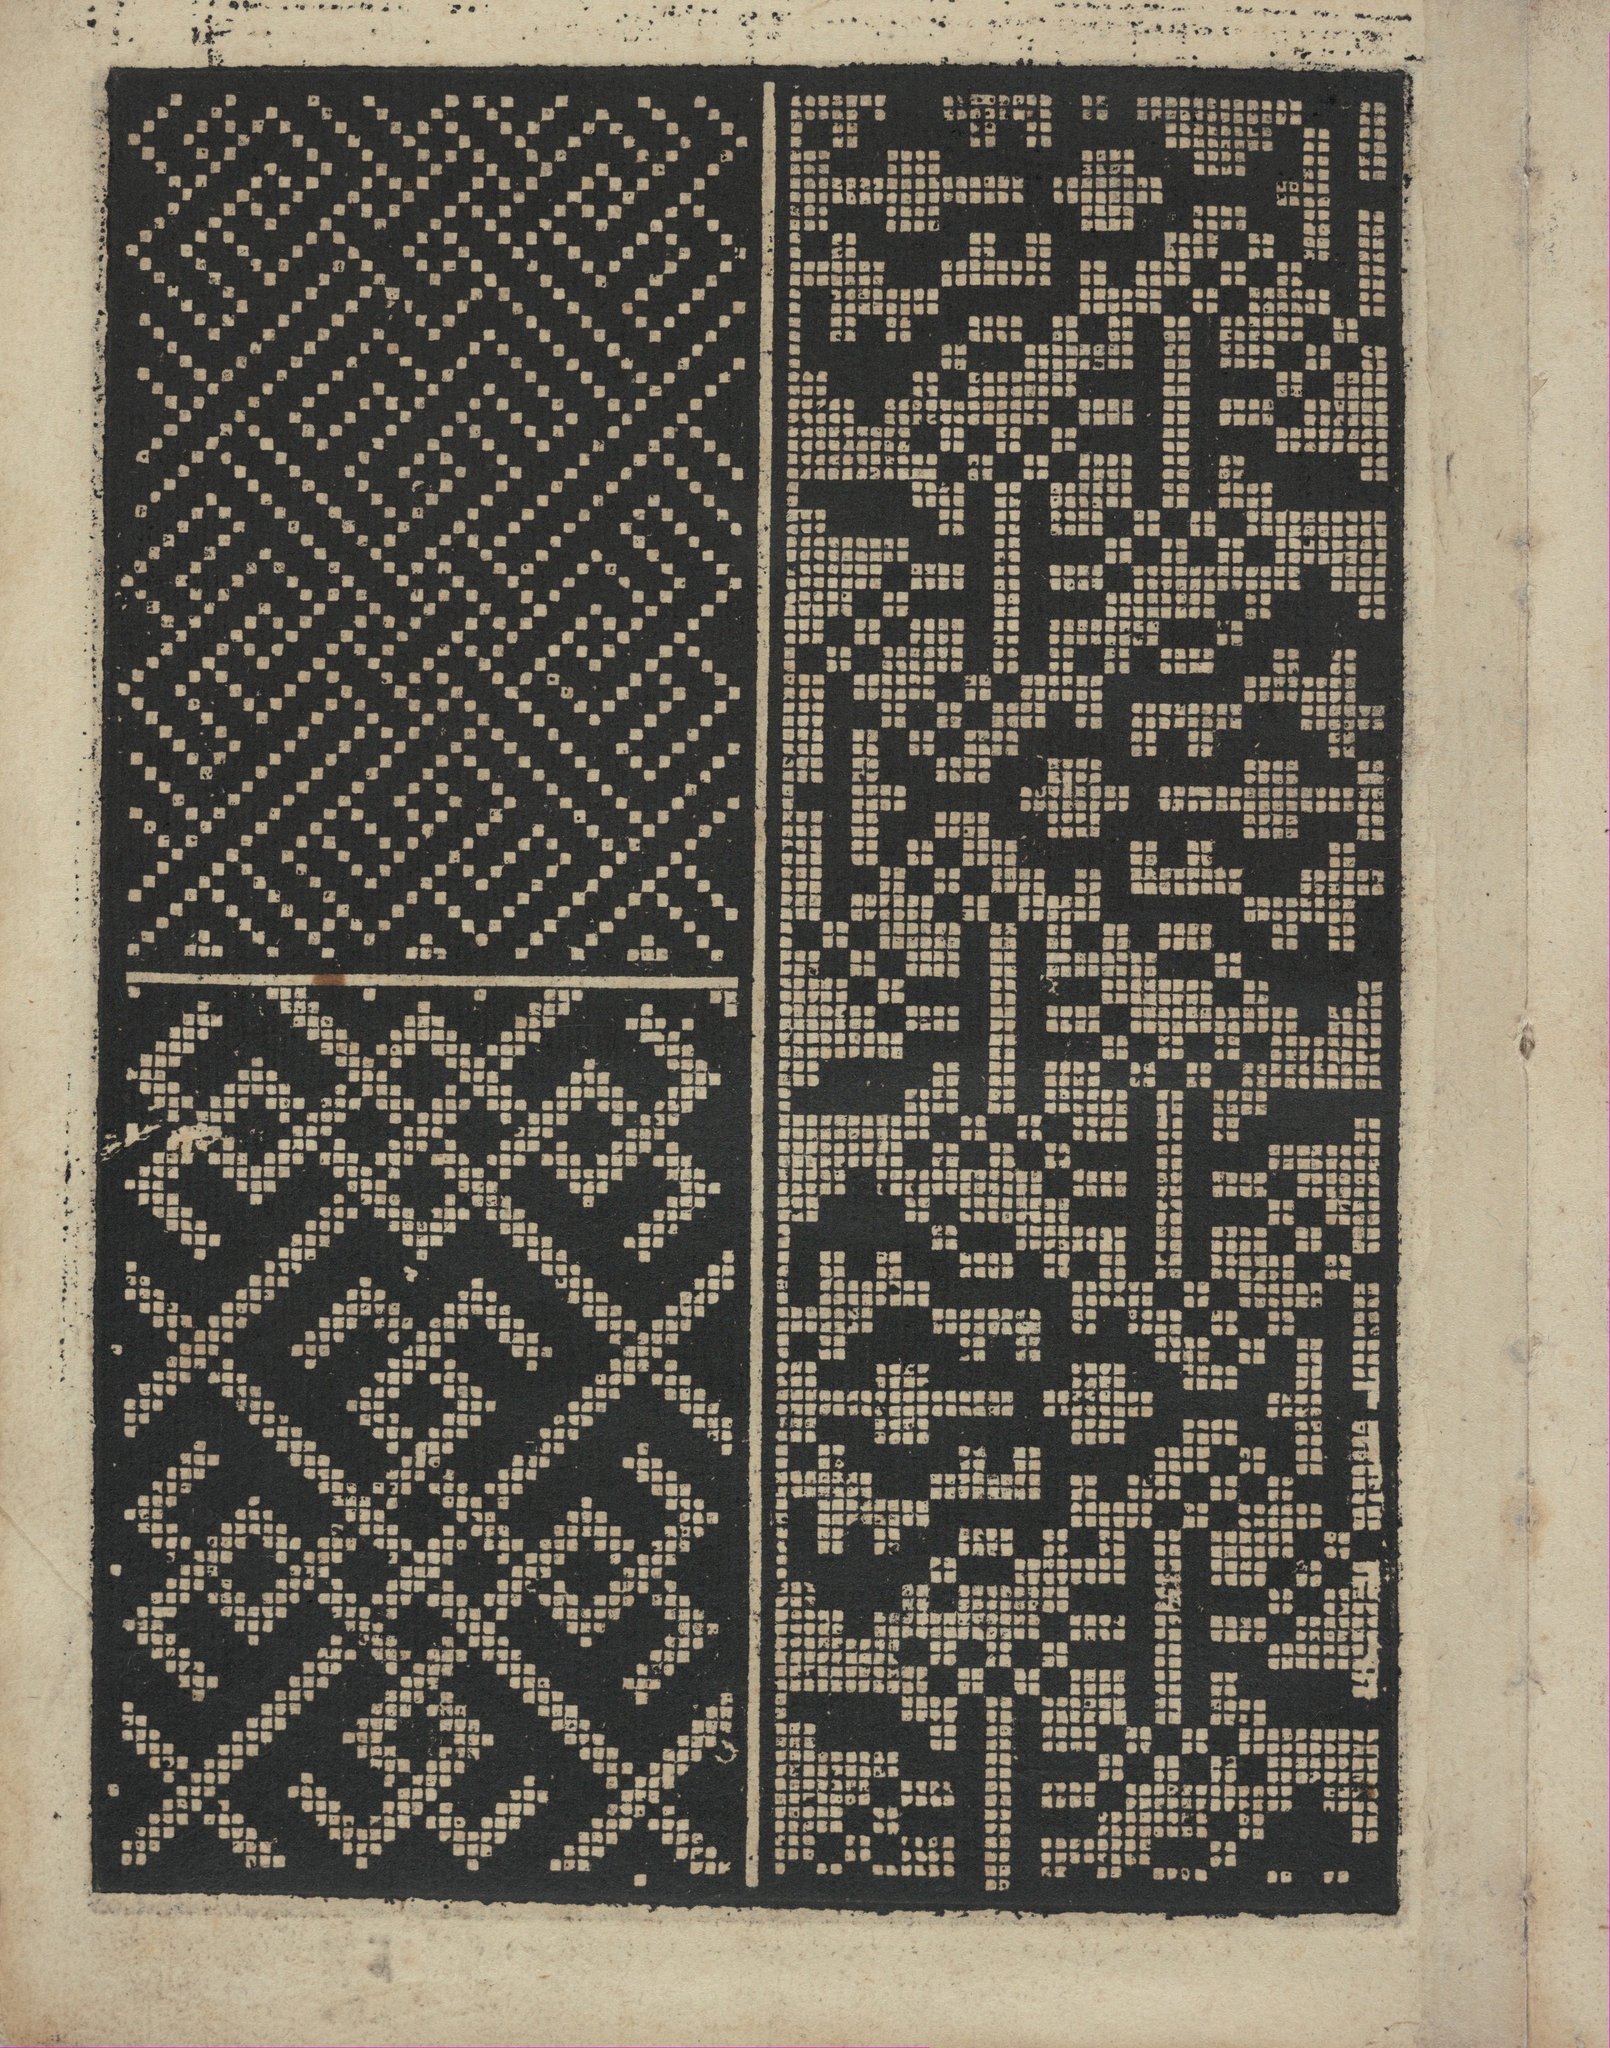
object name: book print ornament architecture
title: Libbretto nouellamete composto per maestro Domenico da Sera...lauorare di ogni sorte di punti, page 10 (verso)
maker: domenico da sera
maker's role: publisher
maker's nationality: french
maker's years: 1500-1599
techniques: woodcut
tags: ornament